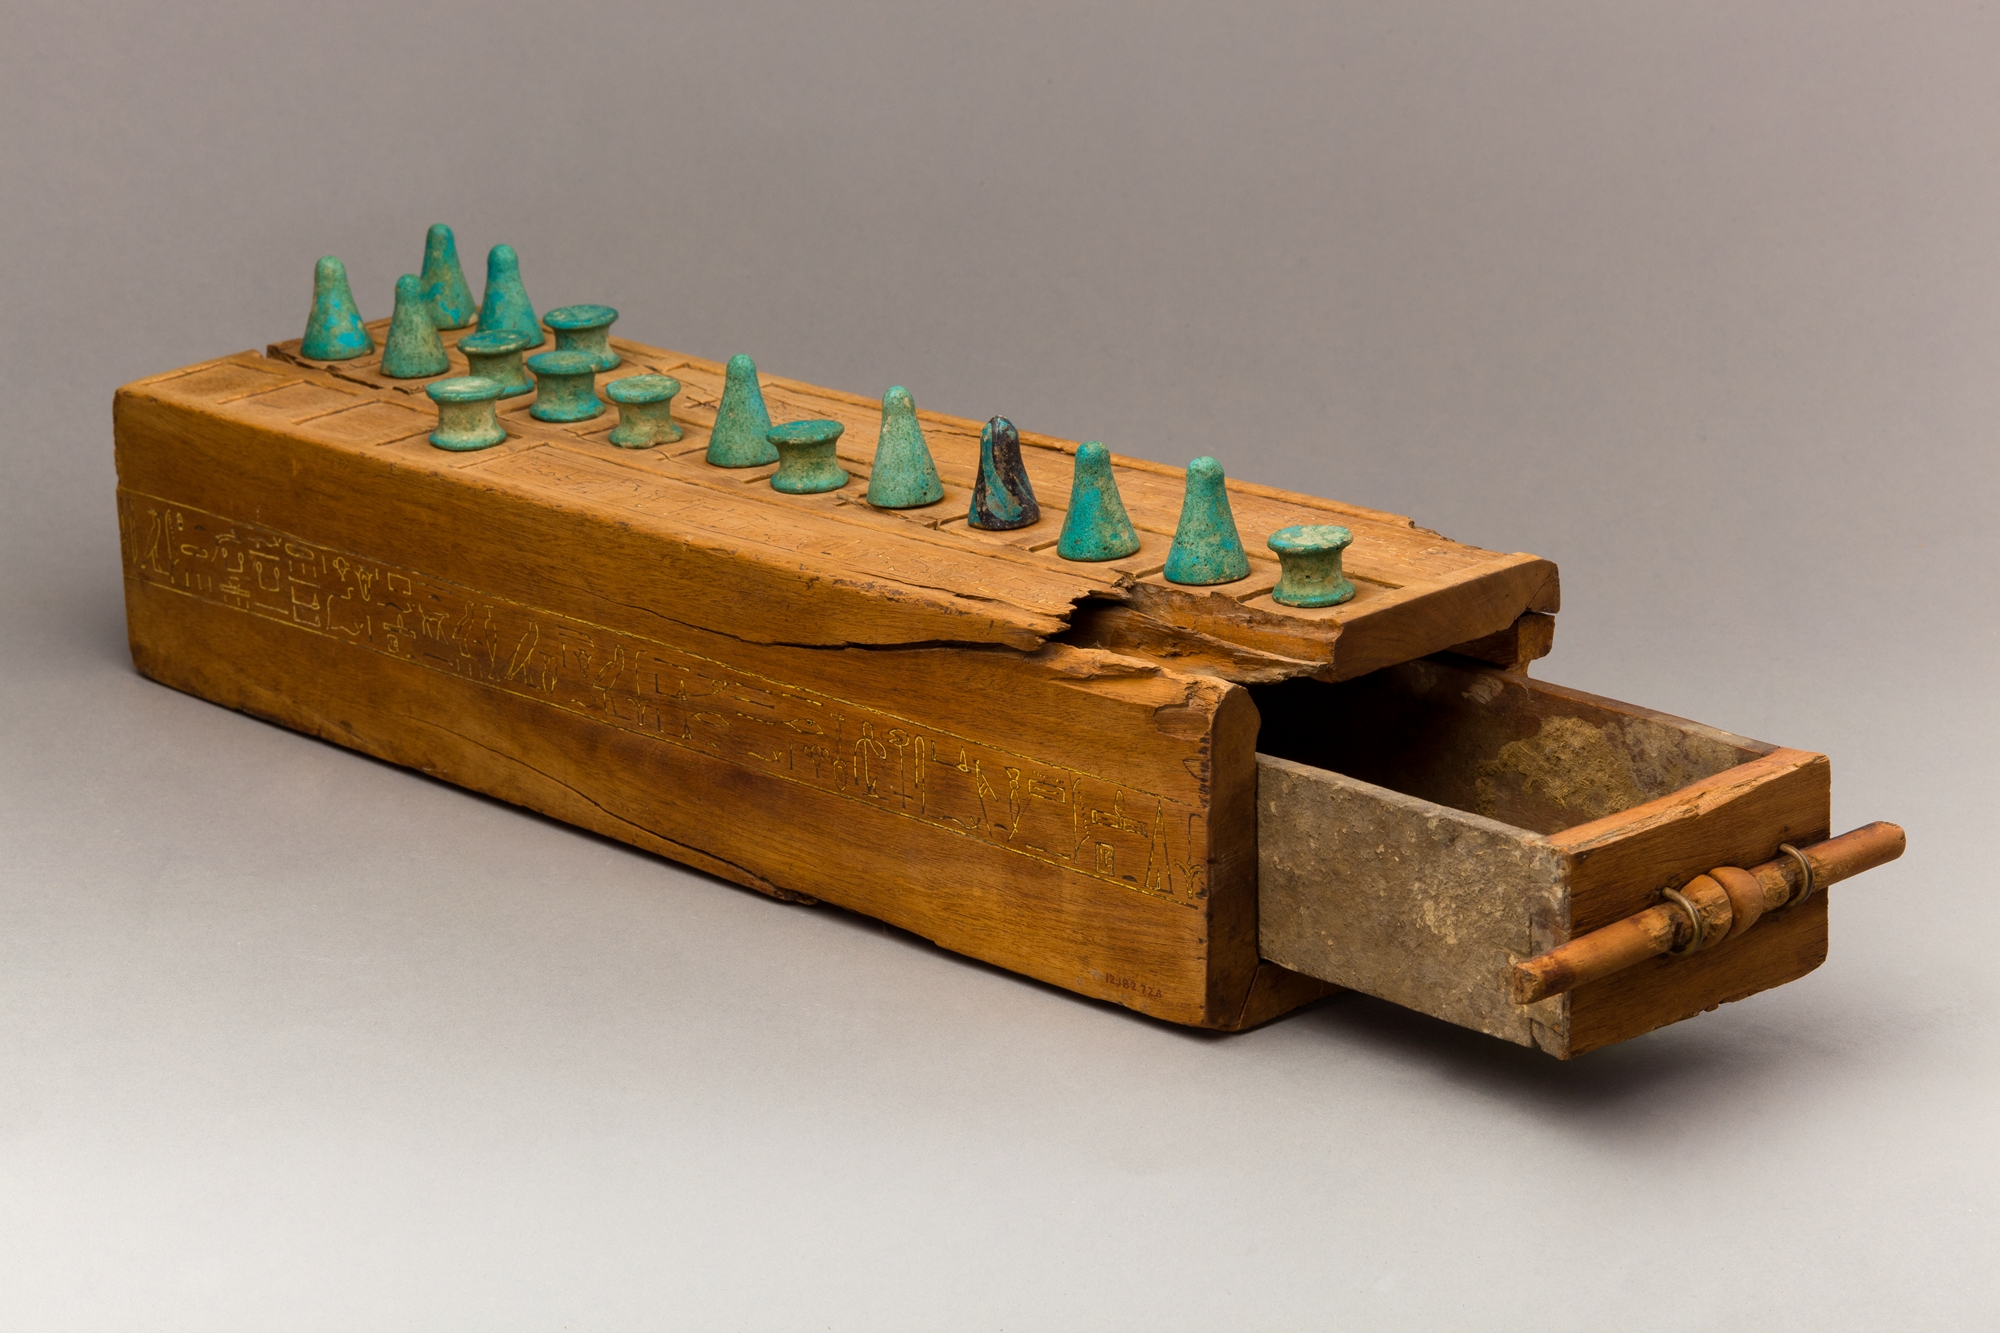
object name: game piece 16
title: Game Pieces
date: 1550-1295 BCE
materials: faience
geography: egypt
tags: games